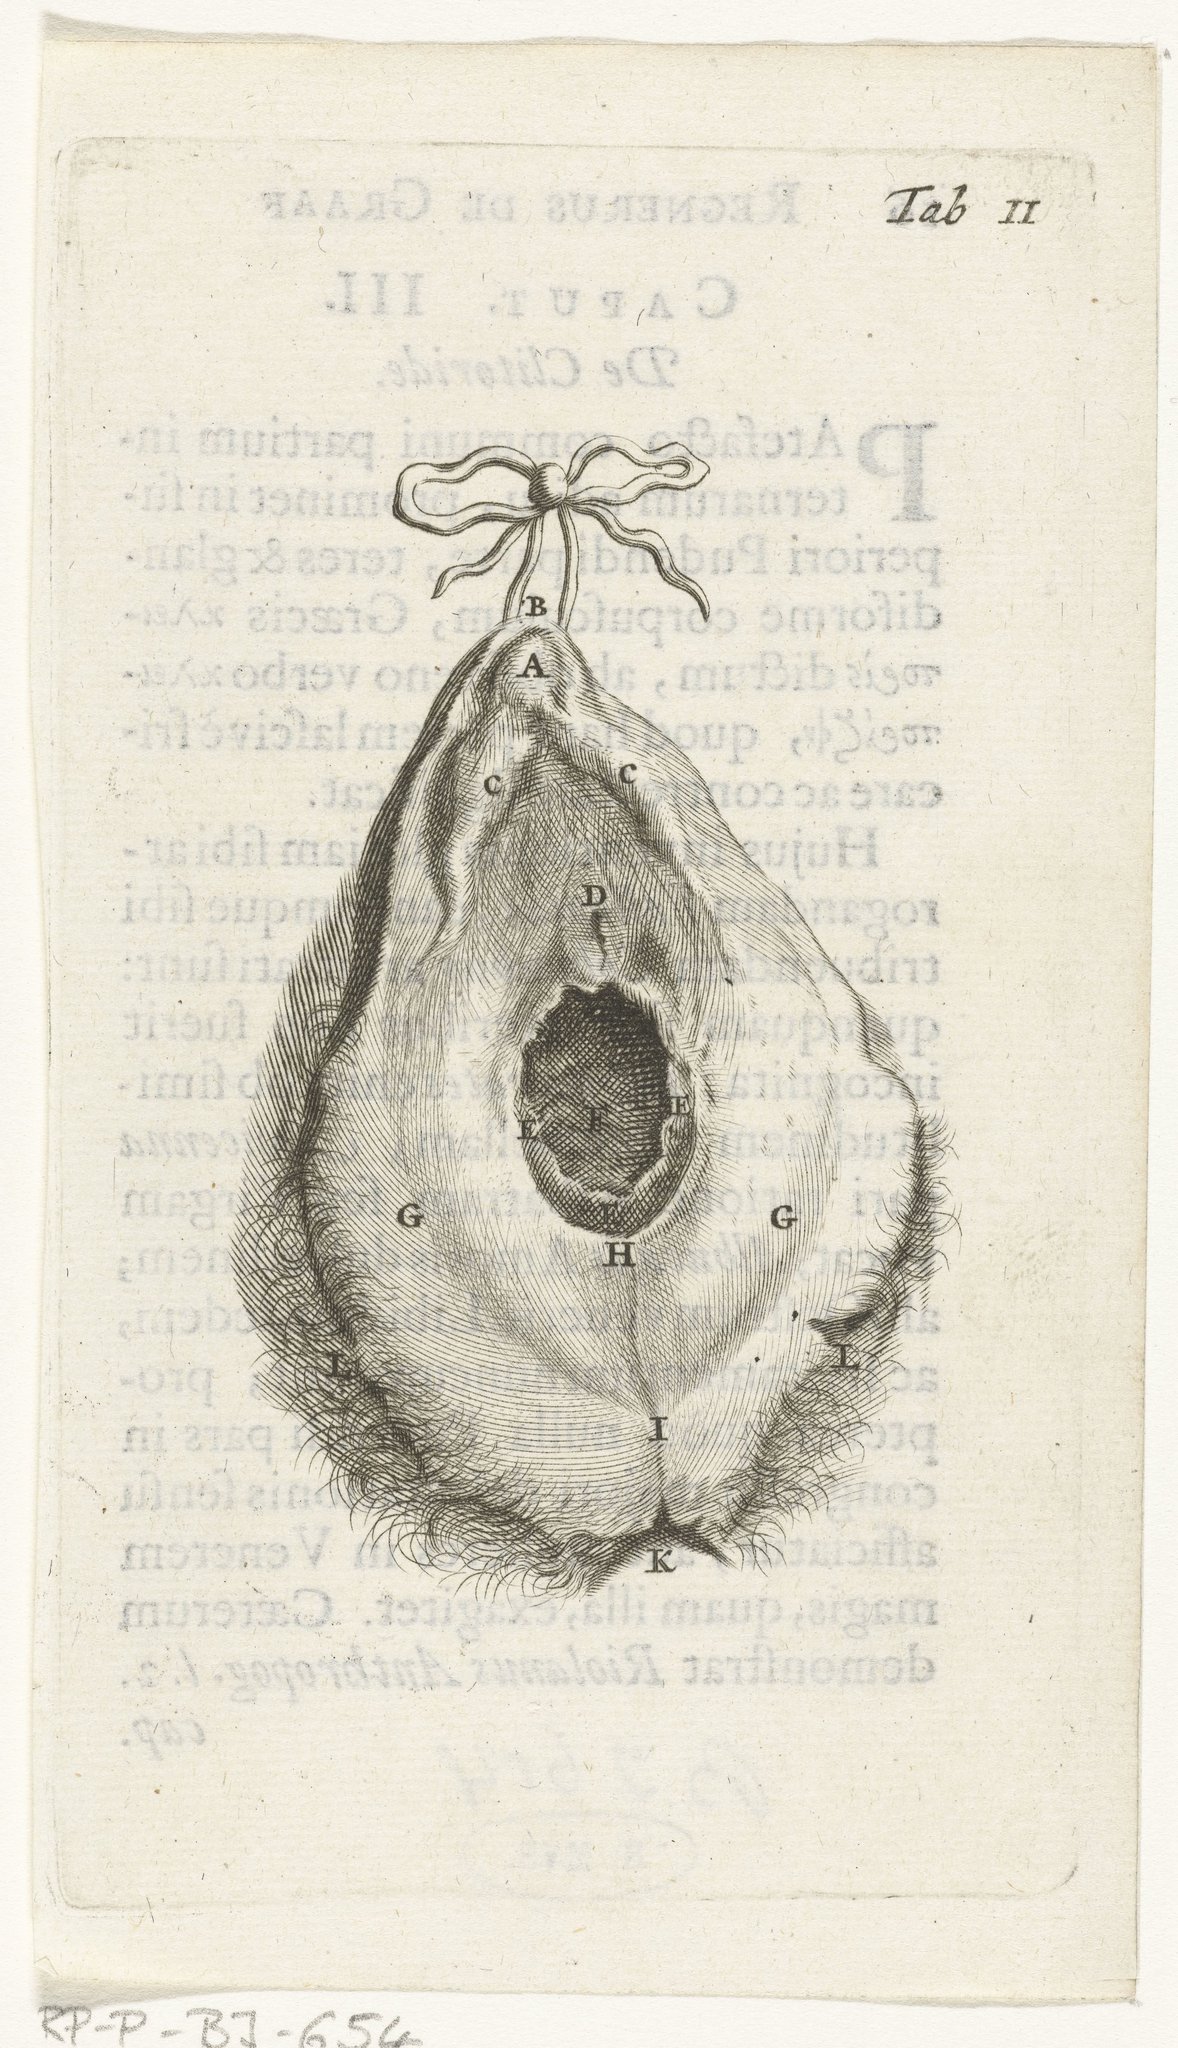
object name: book illustration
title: Prints of the Female Reproductive Organs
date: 1672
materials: paper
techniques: engraving, letterpress printing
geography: leiden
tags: female sexual organs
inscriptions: collector's mark: Lugt 2228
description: In 1672, physician and anatomist Reinier de Graaf published his De mulierum organis about the female reproductive organs. The book contains detailed prints by Hendrik Bary, among them several of the vagina. De Graaf was the first to conclude that a foetus was the product not just of a man’s seed, but also of a woman’s egg. He discovered what he called blisters, which later became known as Graafian follicles.